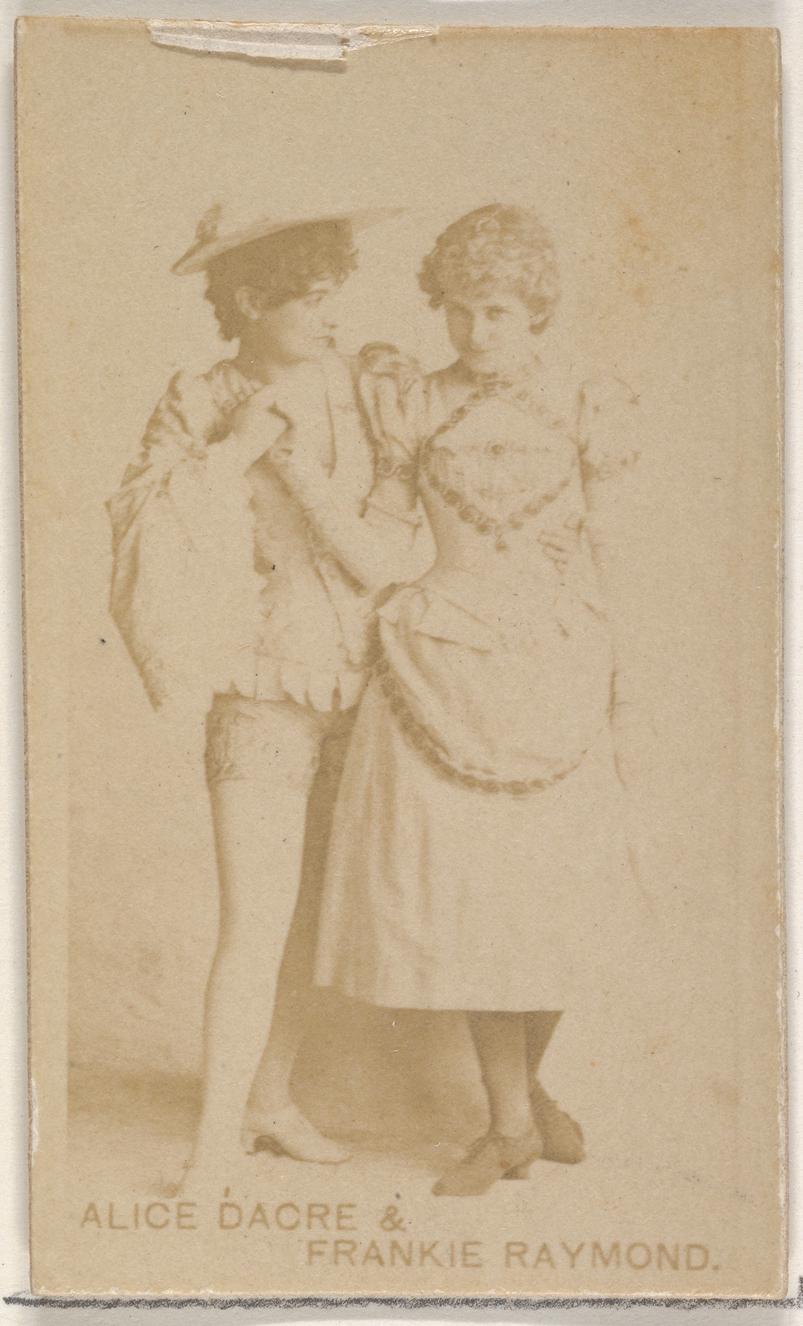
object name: photograph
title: Alice Dacre and Frankie Raymond, from the Actors and Actresses series (N45, Type 8) for Virginia Brights Cigarettes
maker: allen & ginter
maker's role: publisher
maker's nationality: american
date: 1888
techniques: albumen silver print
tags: portraits,women,actresses